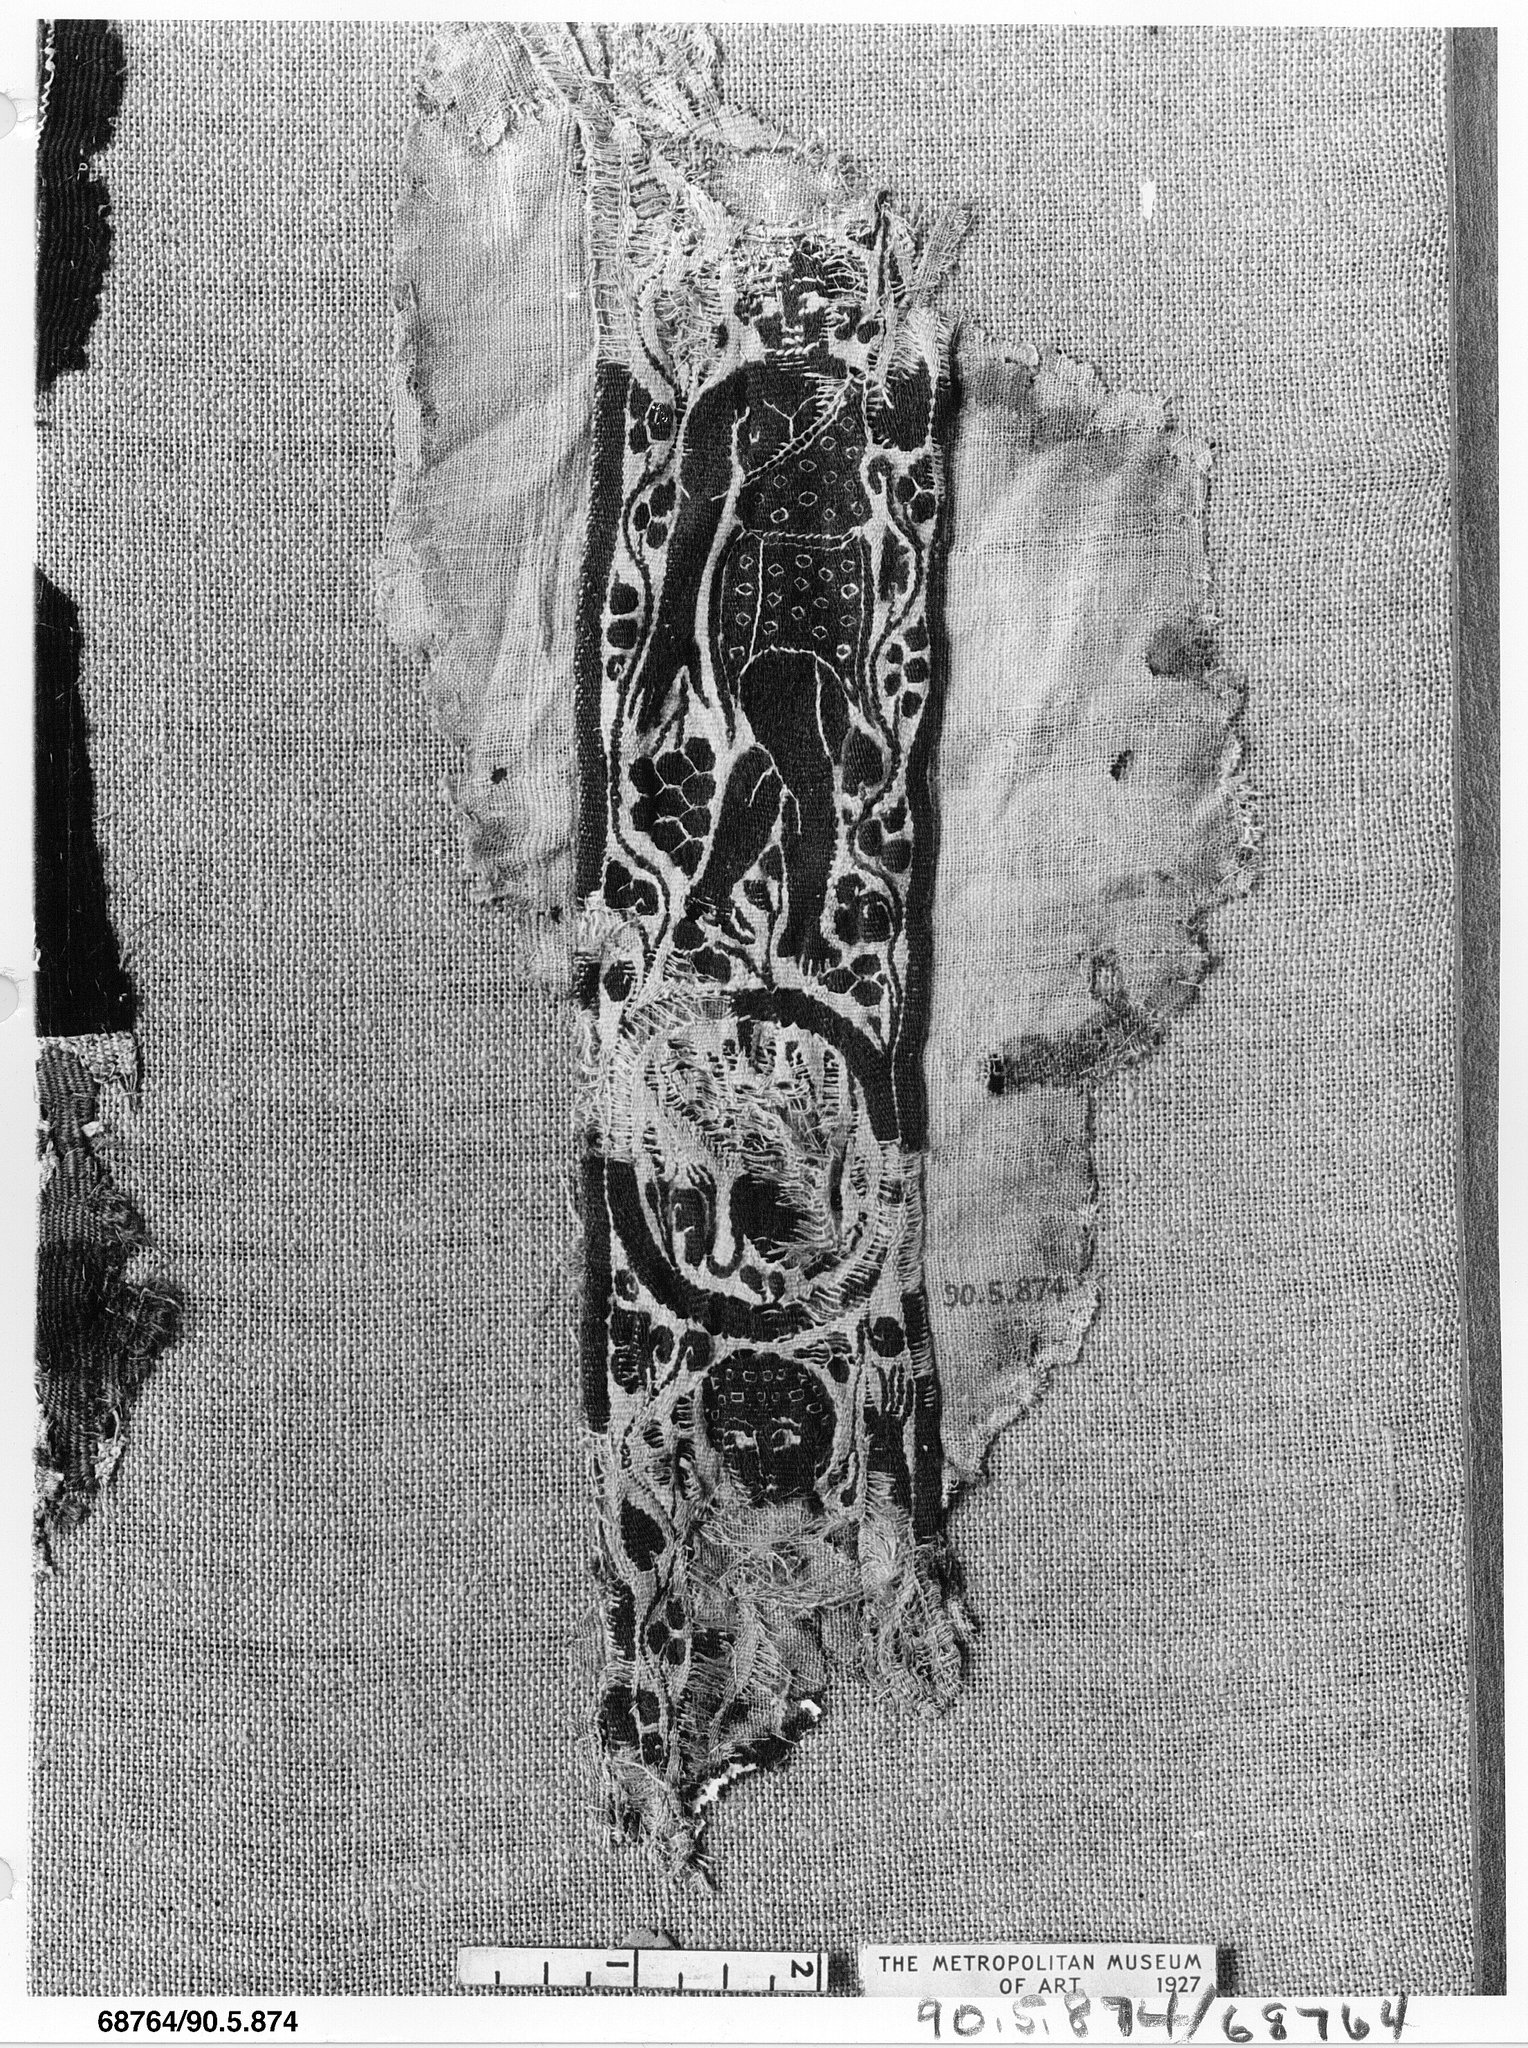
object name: tunic fragment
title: Fragment of a Tunic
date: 201-300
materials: linen, wool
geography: egypt